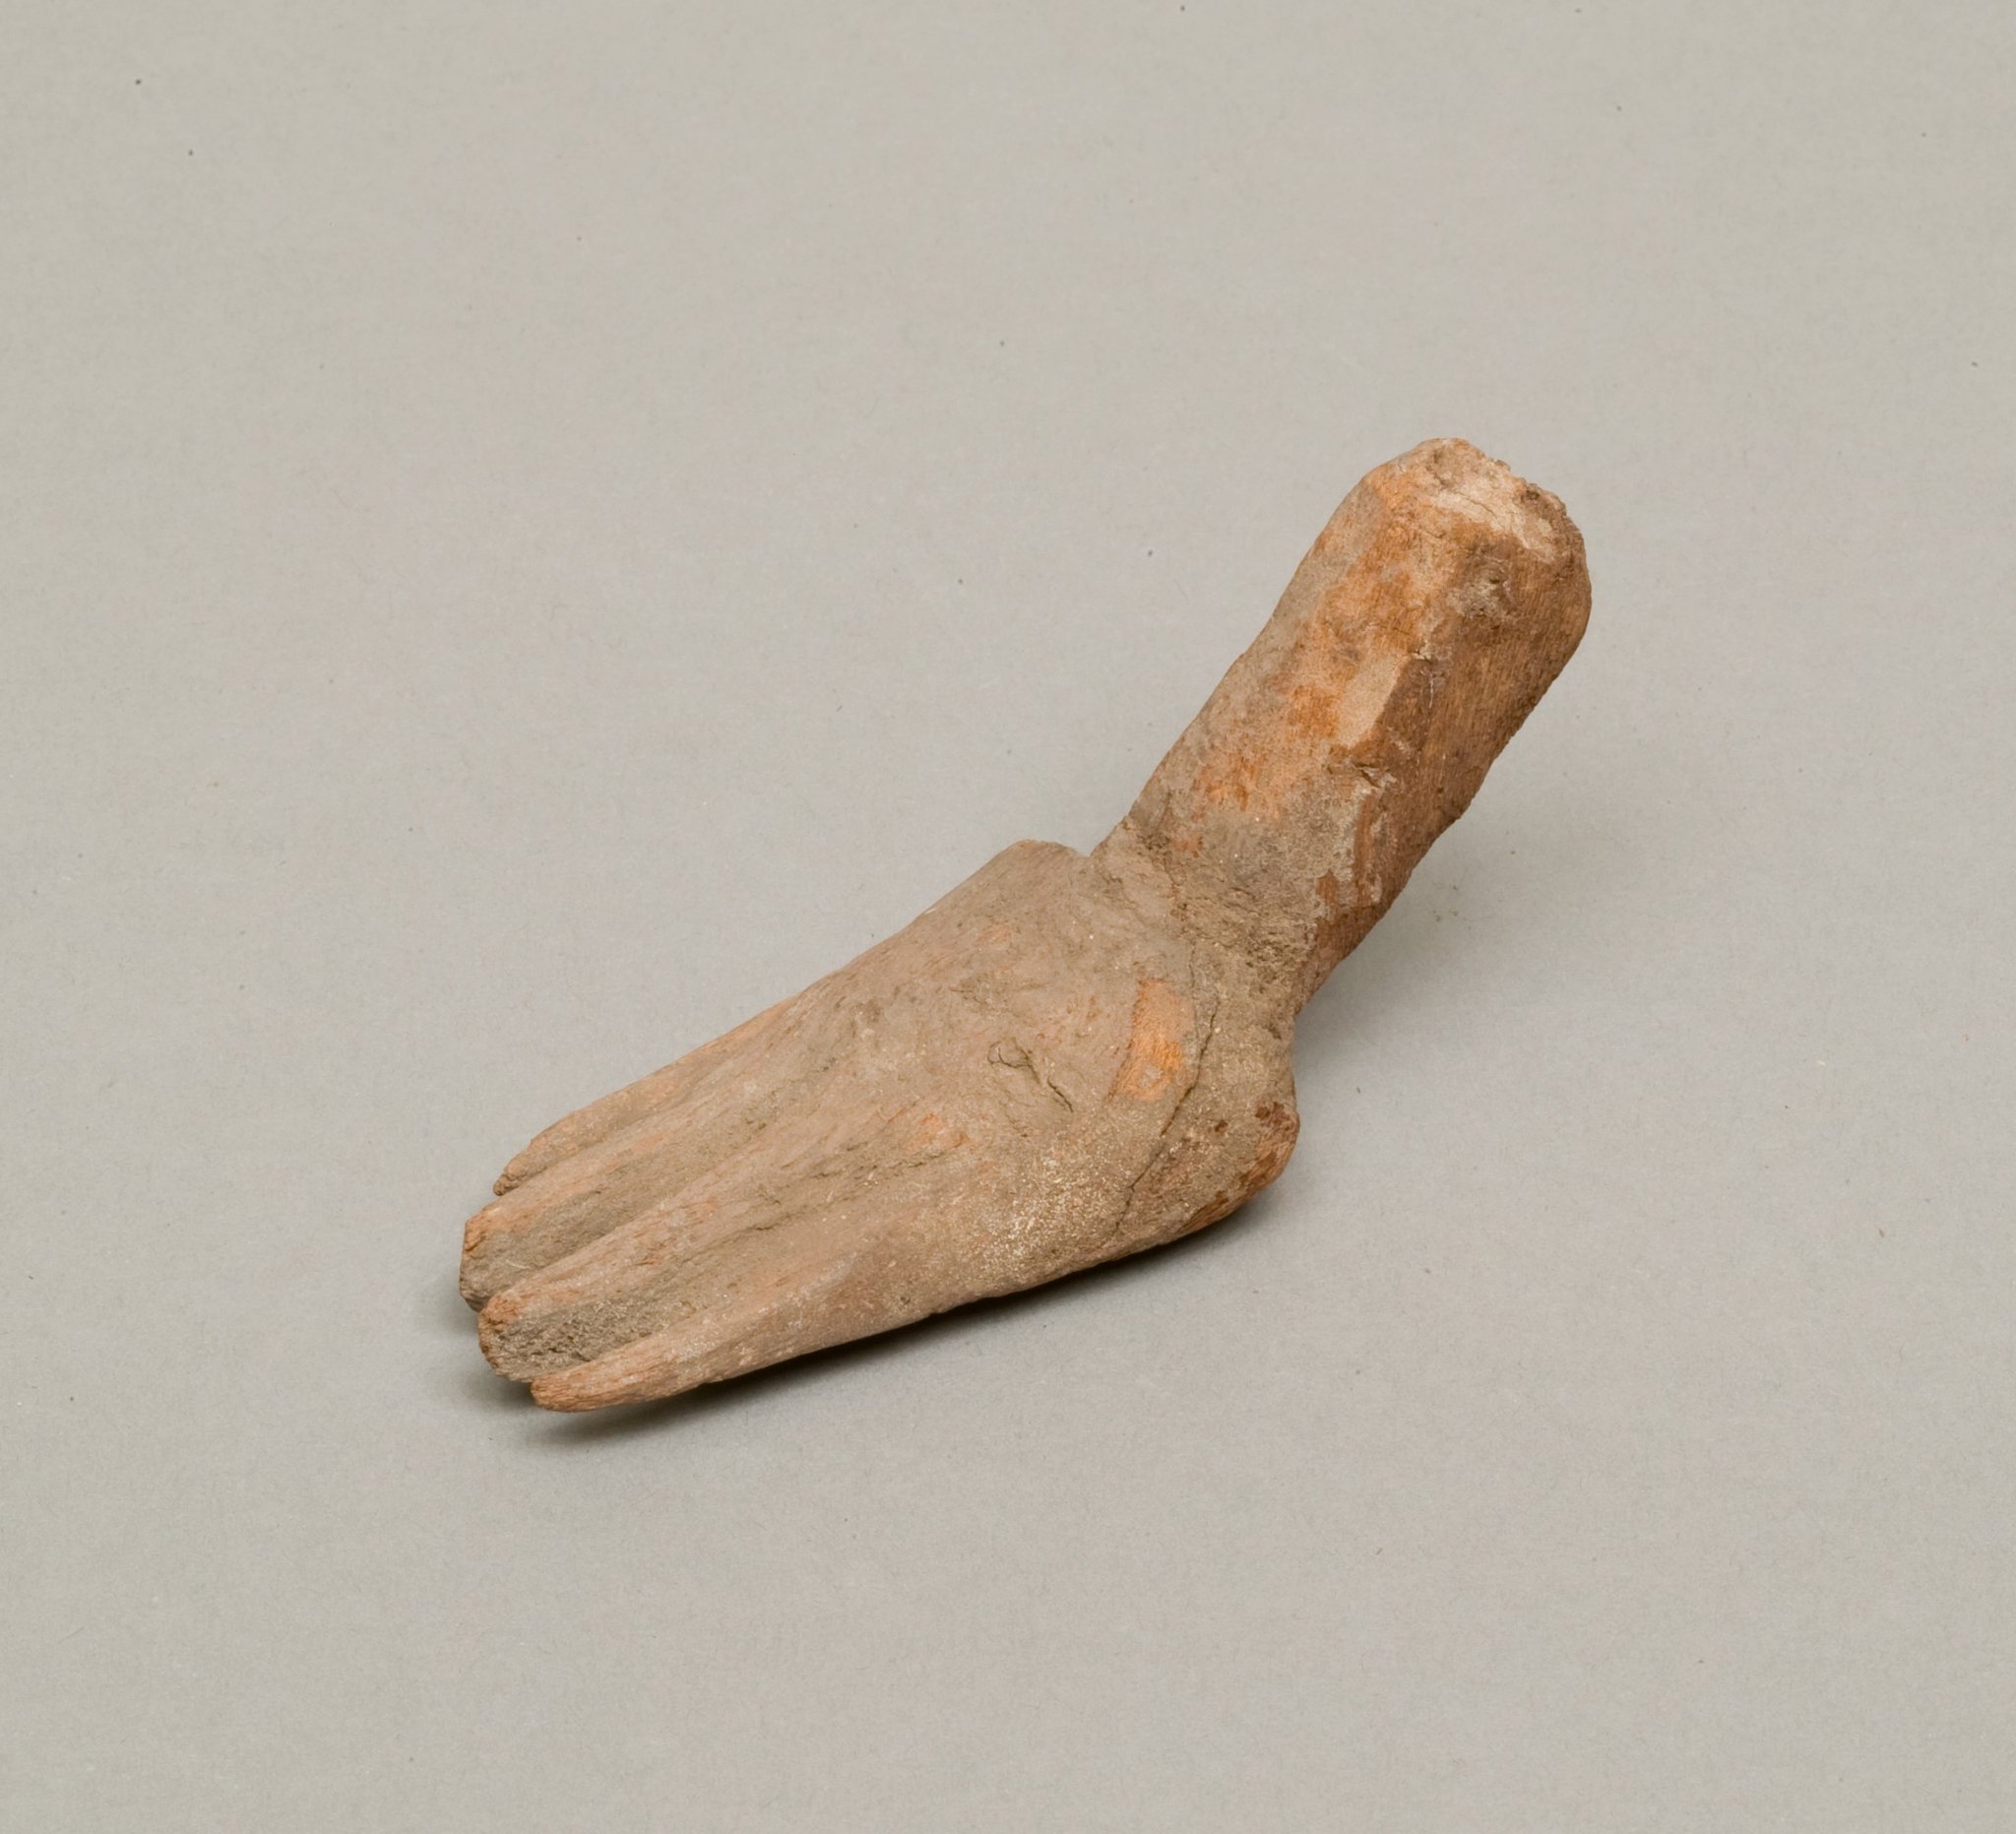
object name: weaving tool beater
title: Weaver's comb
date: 1295-1070 BCE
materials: wood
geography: egypt